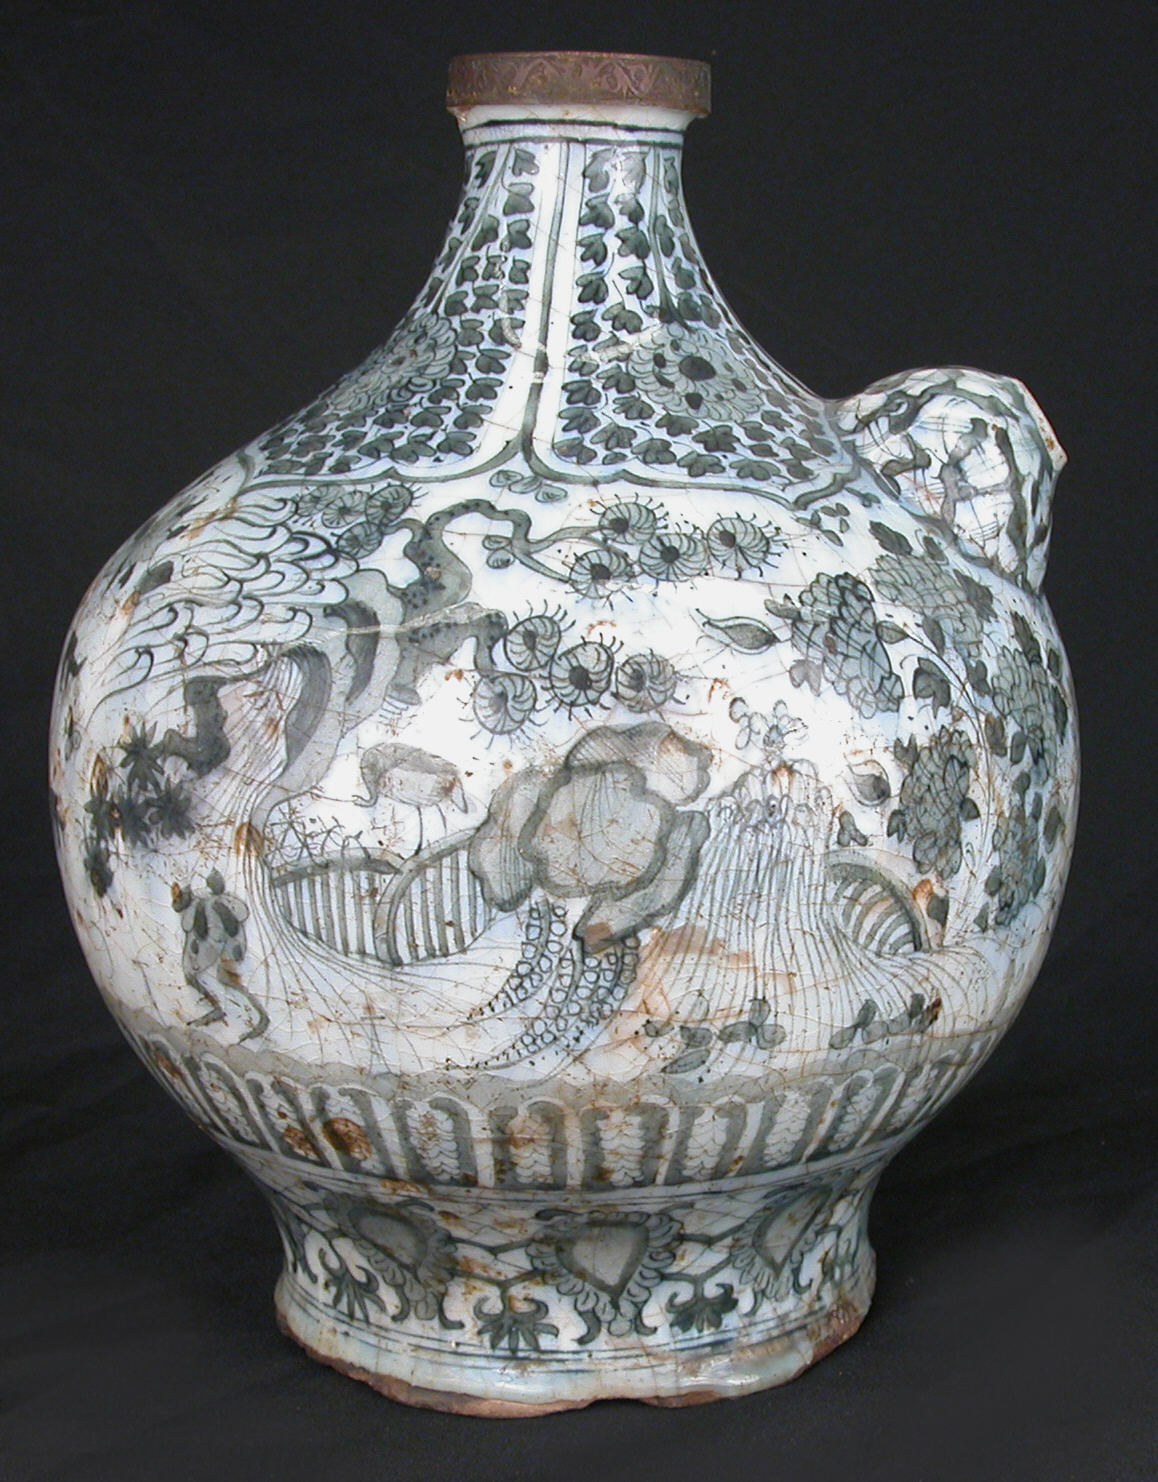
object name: bottle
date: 1701-1750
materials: glaze, stonepaste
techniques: painting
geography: iran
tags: flowers